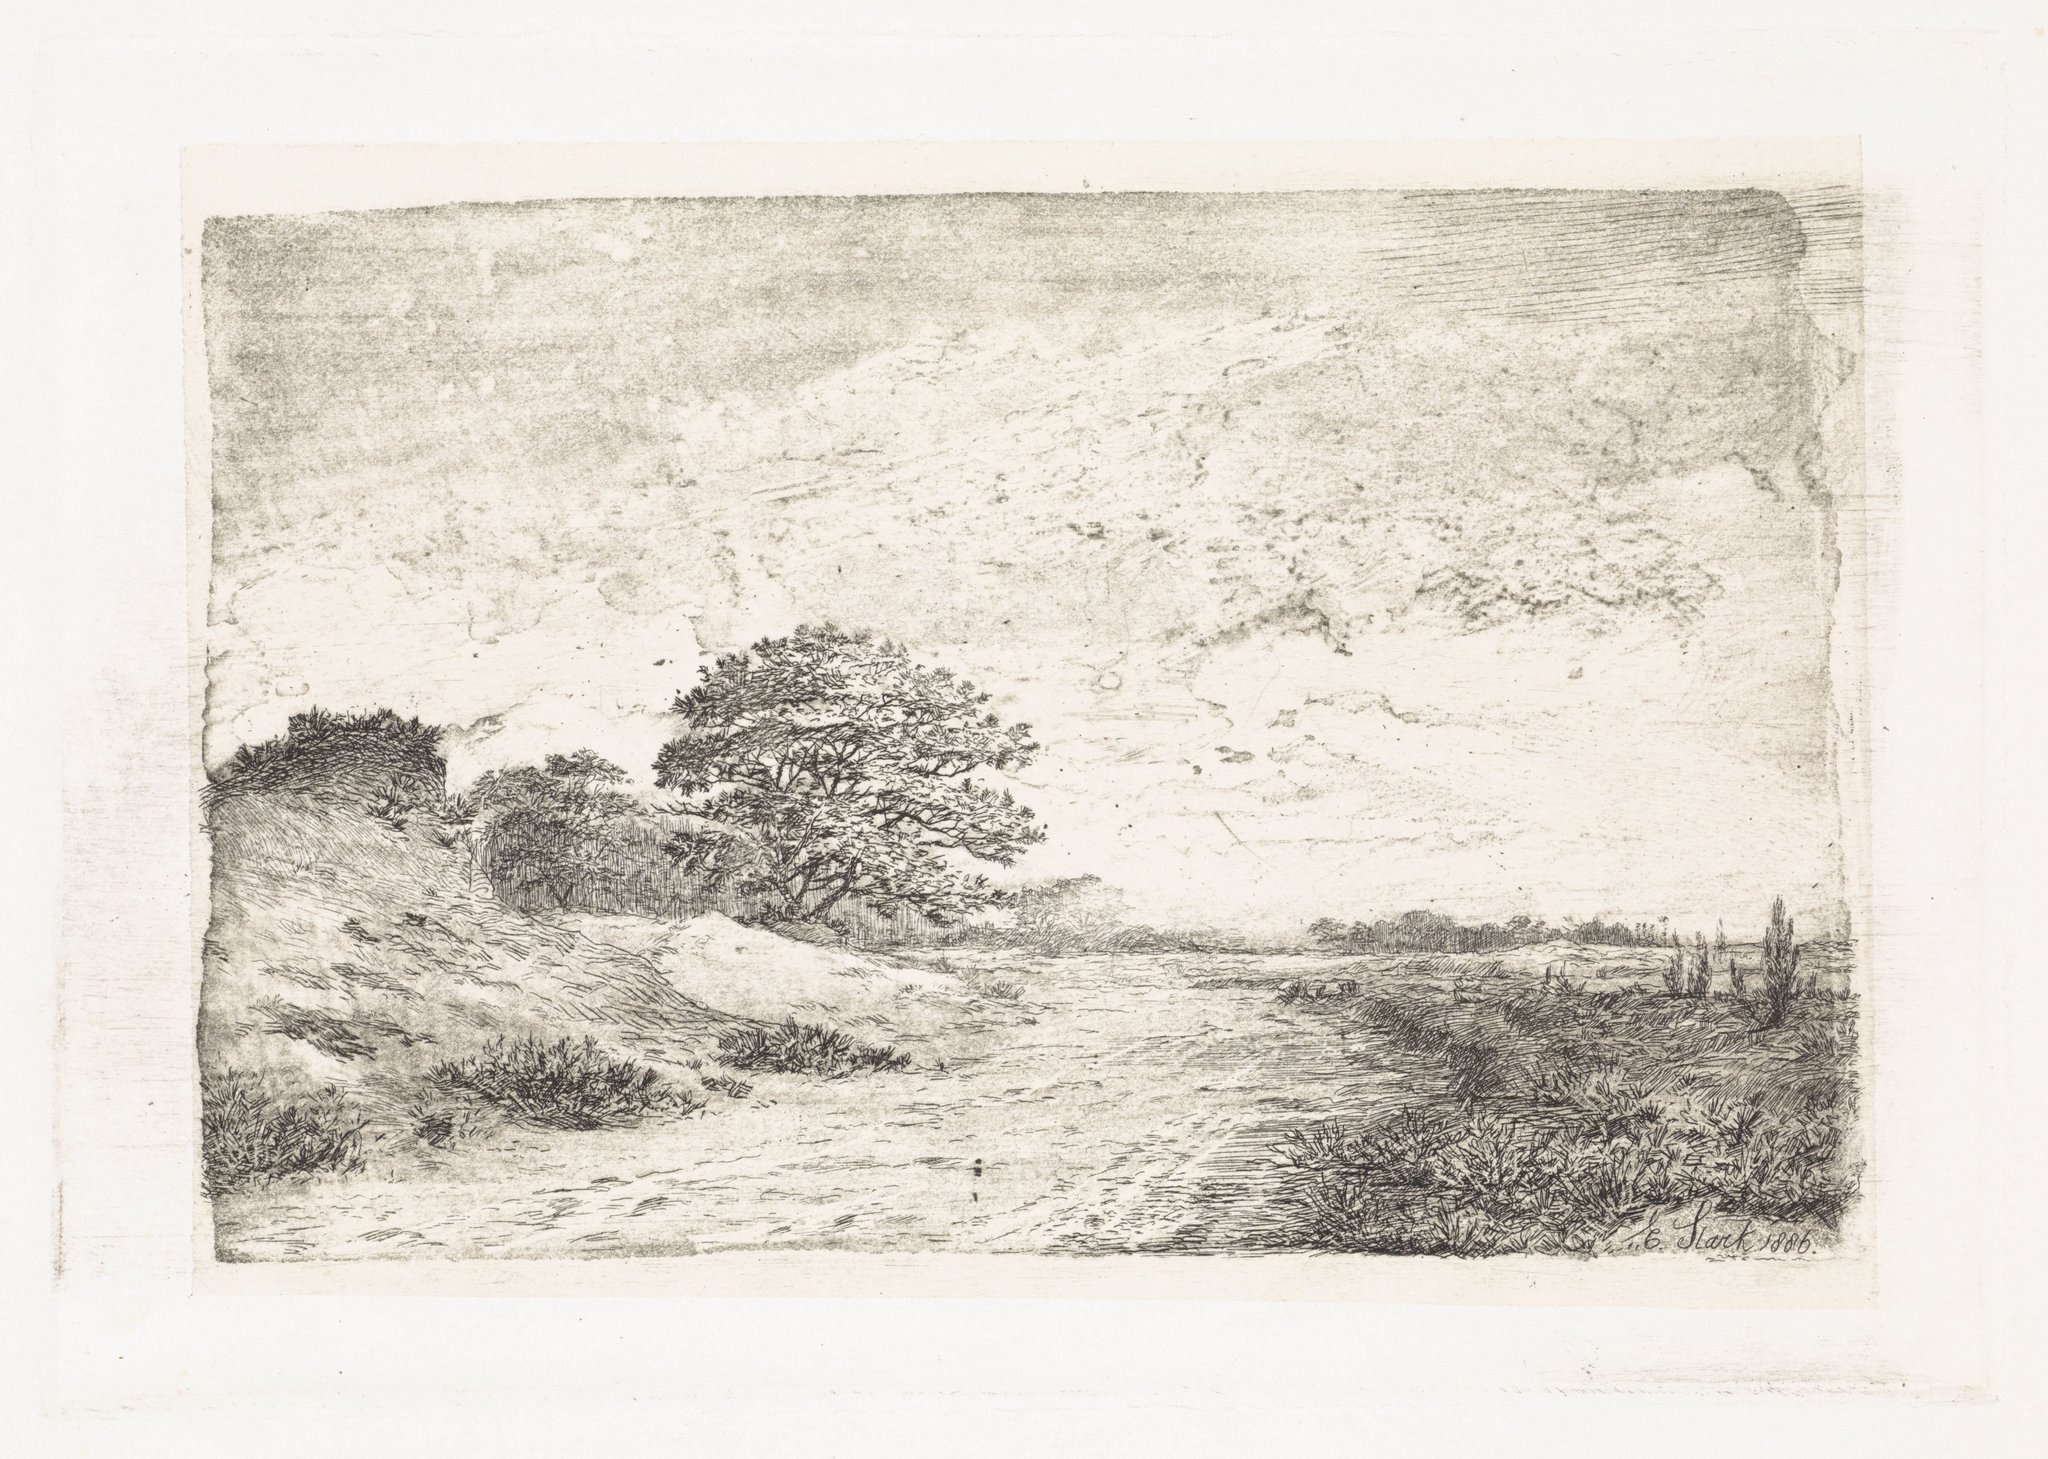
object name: print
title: Duinlandschap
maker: elias stark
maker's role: draughtsman, print maker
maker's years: 1849-1933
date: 1886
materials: paper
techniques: aquatint, etching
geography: nieuwer-amstel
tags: dunes (sea not visible); in the dunes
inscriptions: collector's mark: Lugt 2228